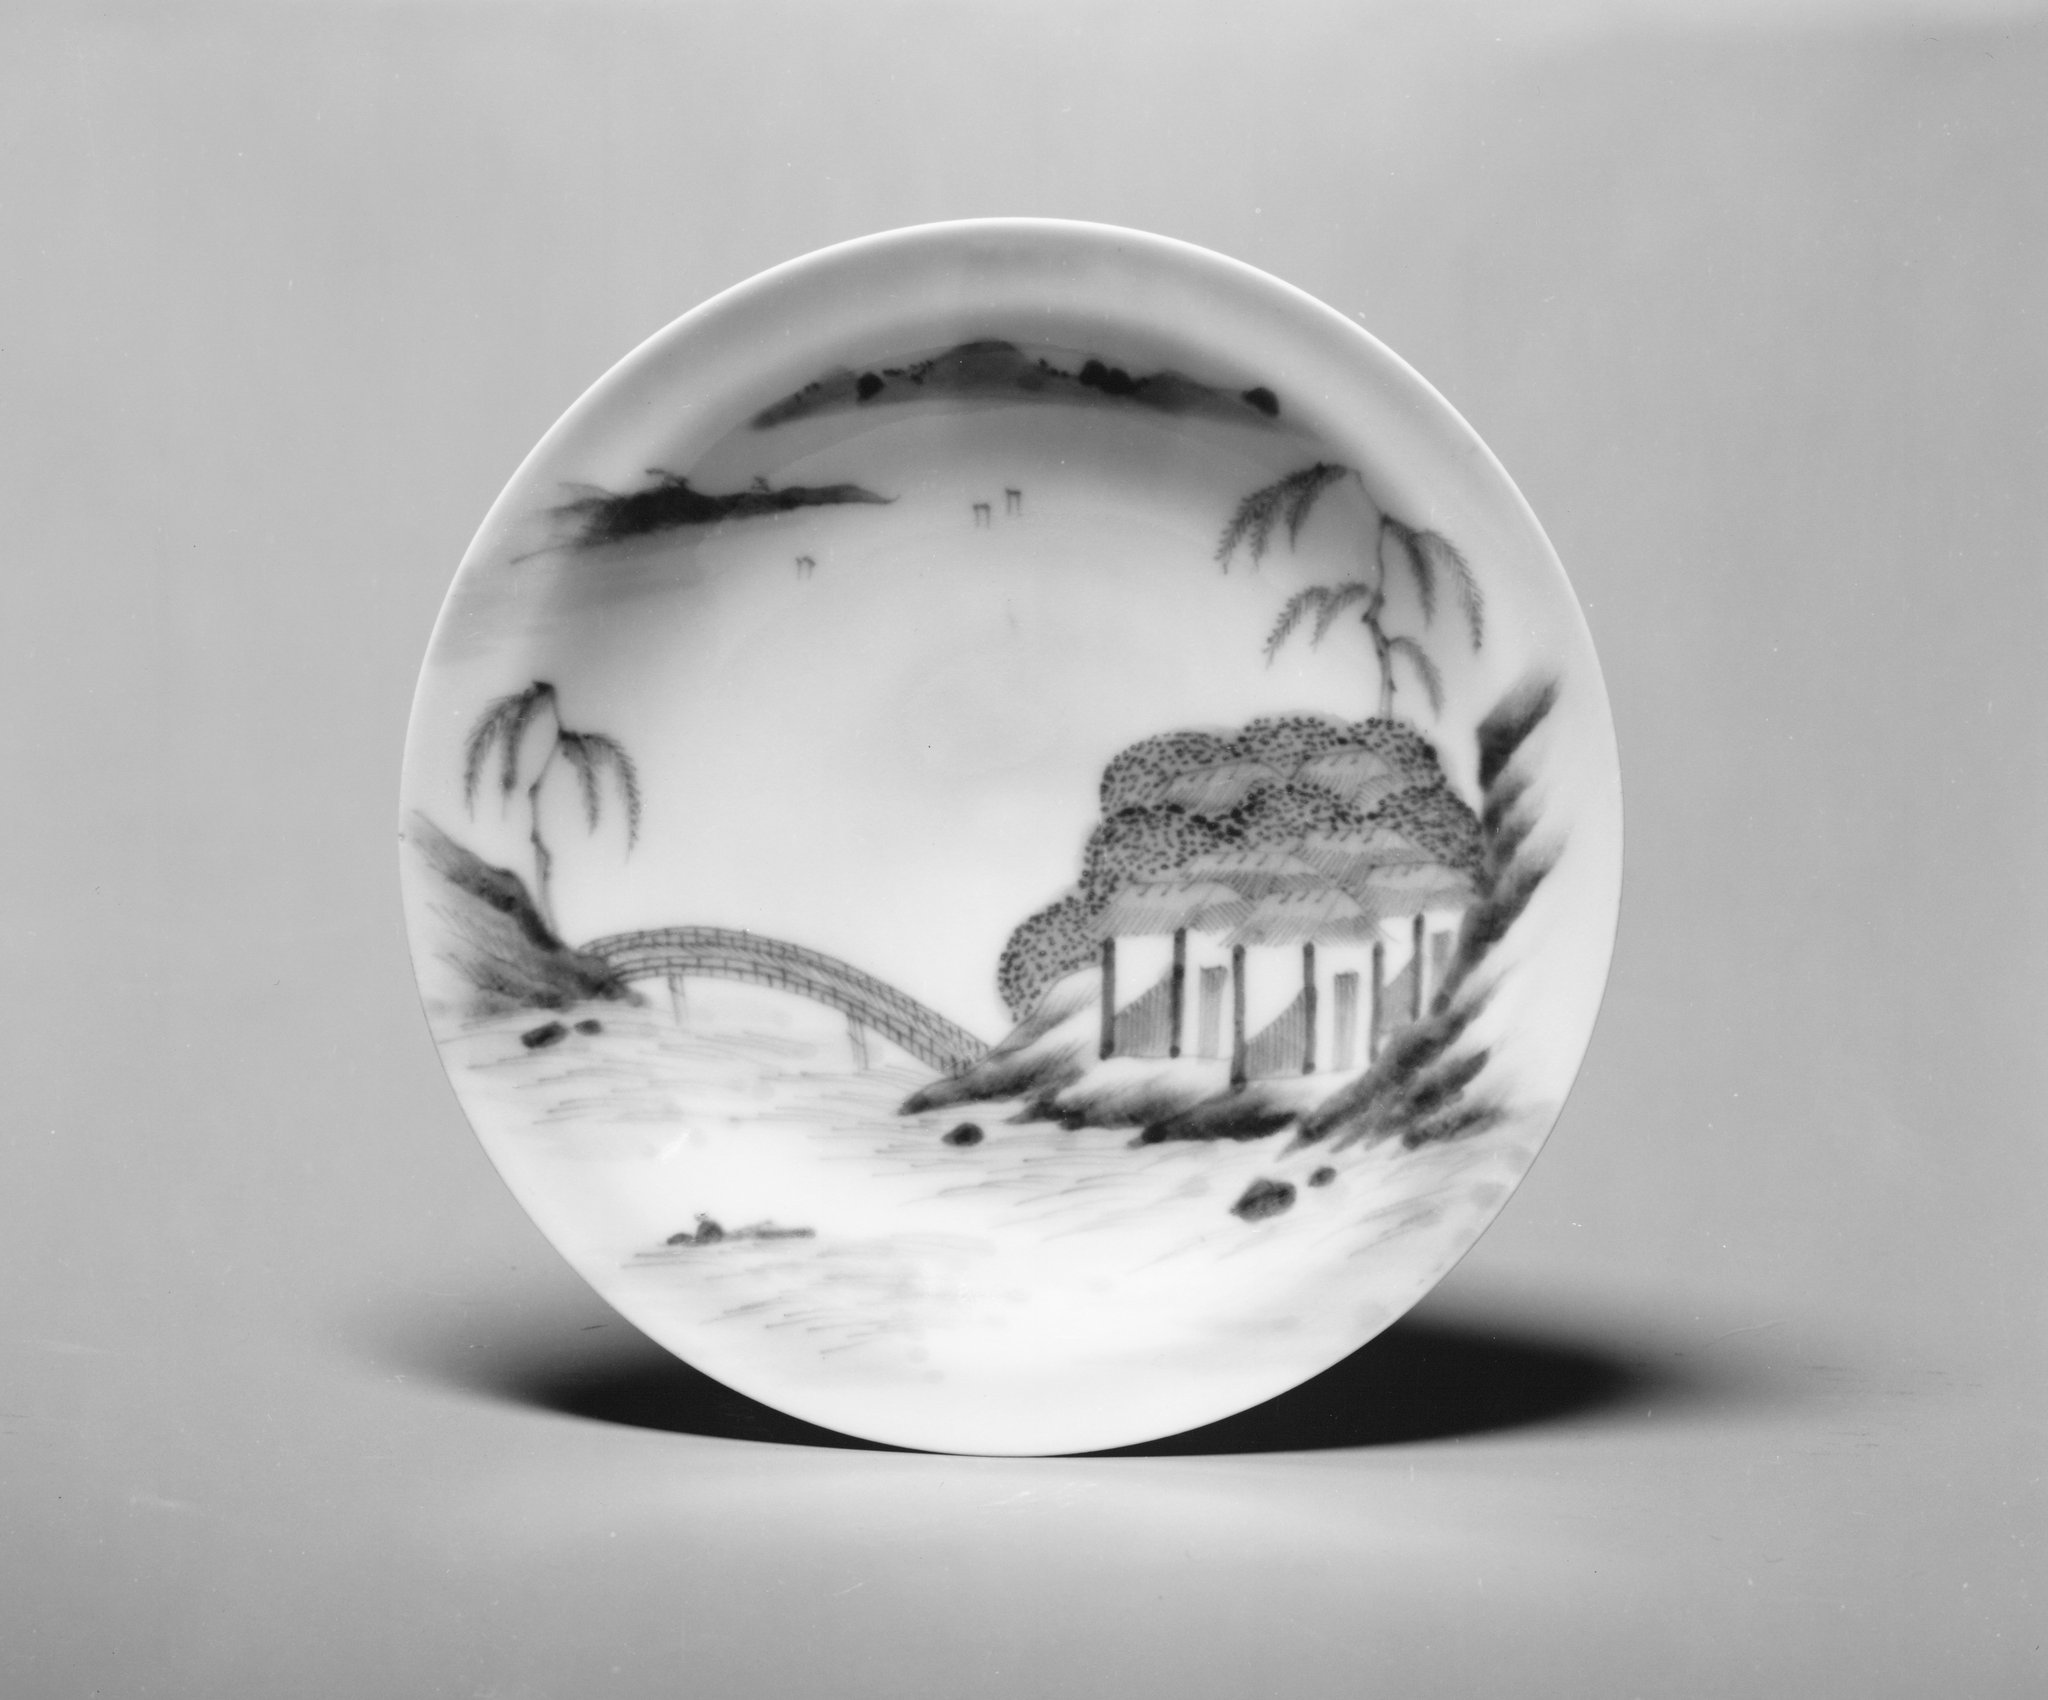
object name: saucer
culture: japanese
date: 1830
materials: glaze, porcelain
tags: bridges